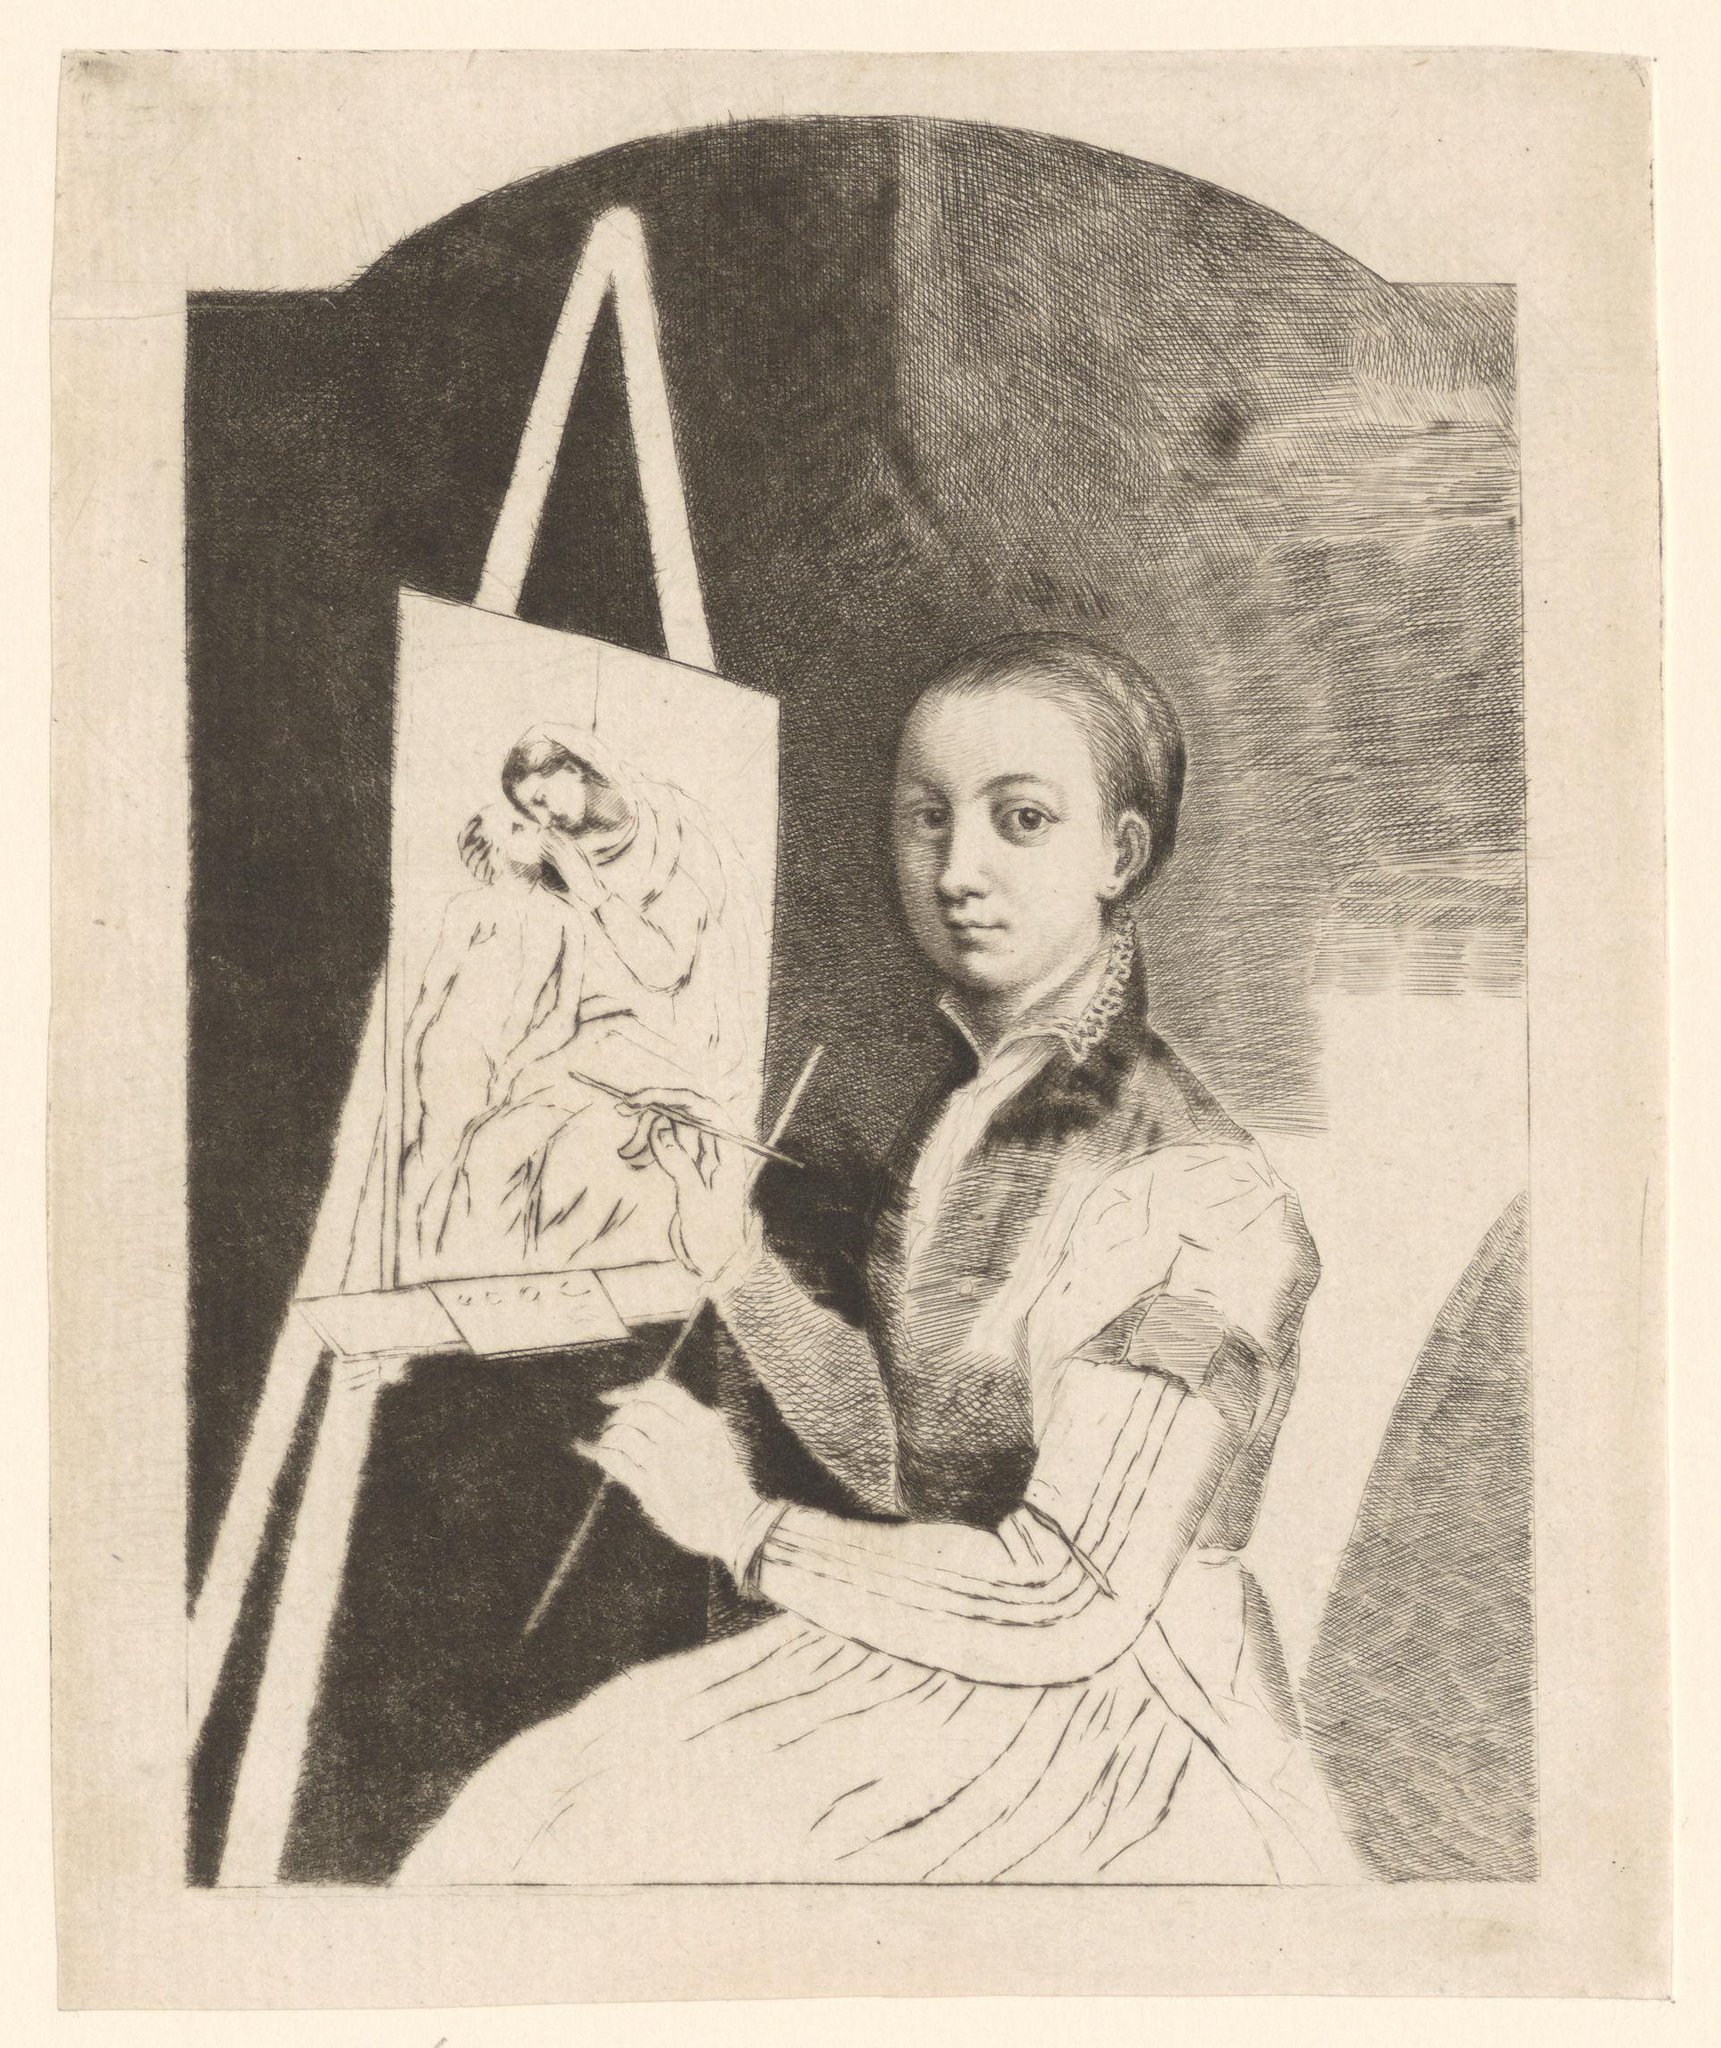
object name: print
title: Portret van Sofonisba Anguissola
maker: thomas worlidge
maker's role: print maker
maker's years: 1700-1766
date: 1710-1766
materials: paper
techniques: drypoint, etching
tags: painter, sofonisba anguissola, historical persons - bb - woman, portrait, self-portrait of painter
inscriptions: collector's mark: Lugt 2760, collector's mark: Lugt 2228